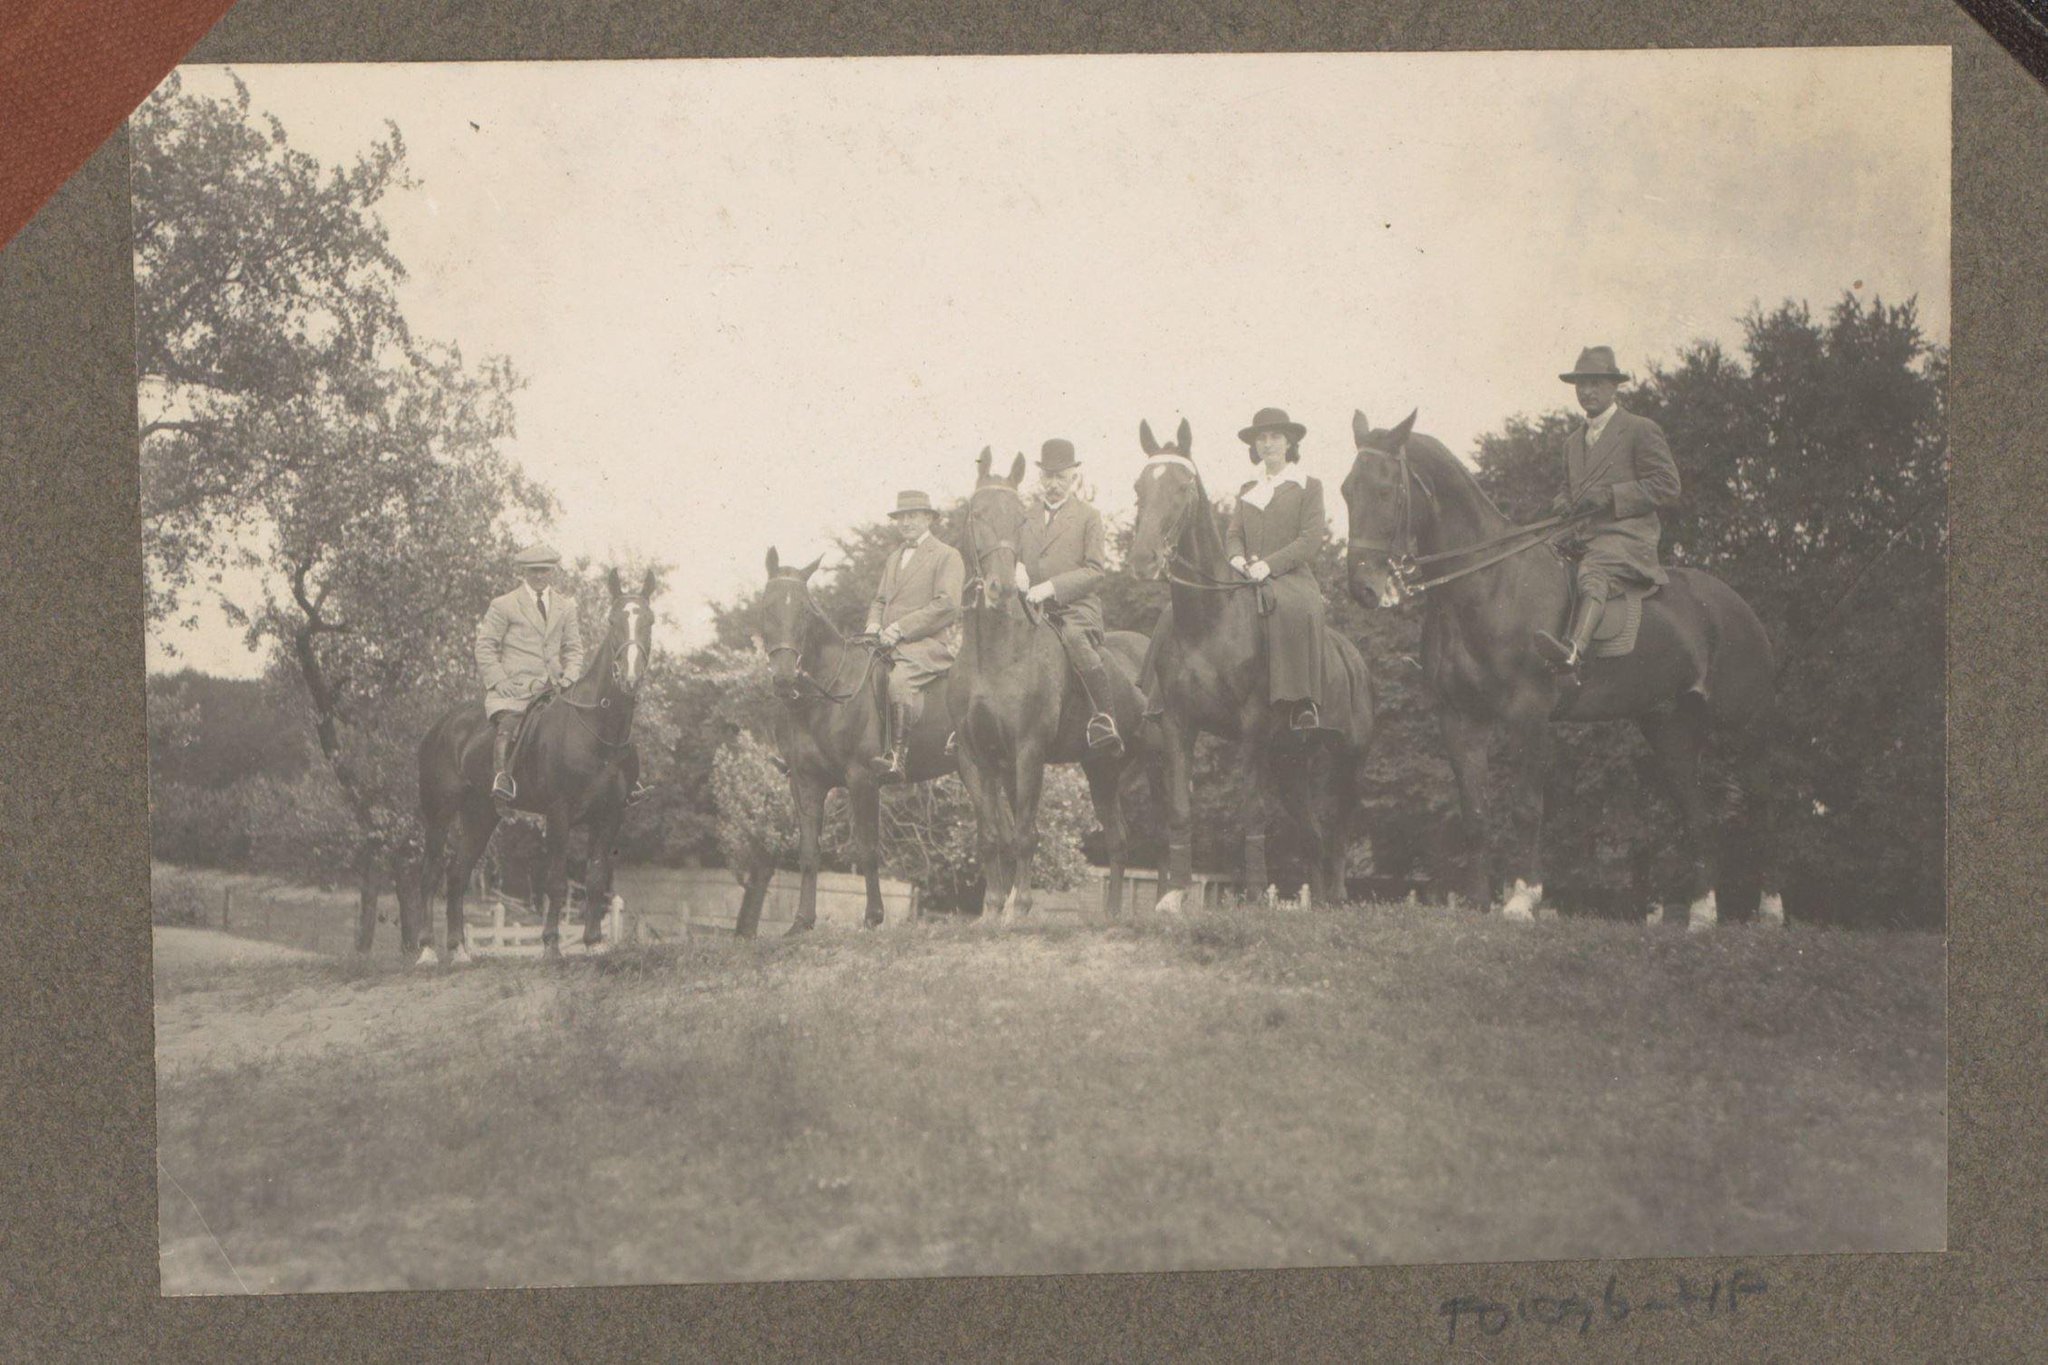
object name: photograph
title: Ruitertafereel op Koninklijke Houtvesterij Het Loo: groep ruiters op een helling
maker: Anonymous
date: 1900-1925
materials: photographic support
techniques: gelatin silver print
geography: het loo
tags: riding a horse, ass, or mule; rider, horseman, hunting, chase, hunting-ground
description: Onderdeel van Fotoalbum van de heer Brams, opperhoutvester van koningin Wilhelmina op Koninklijke Houtvesterij Het Loo.